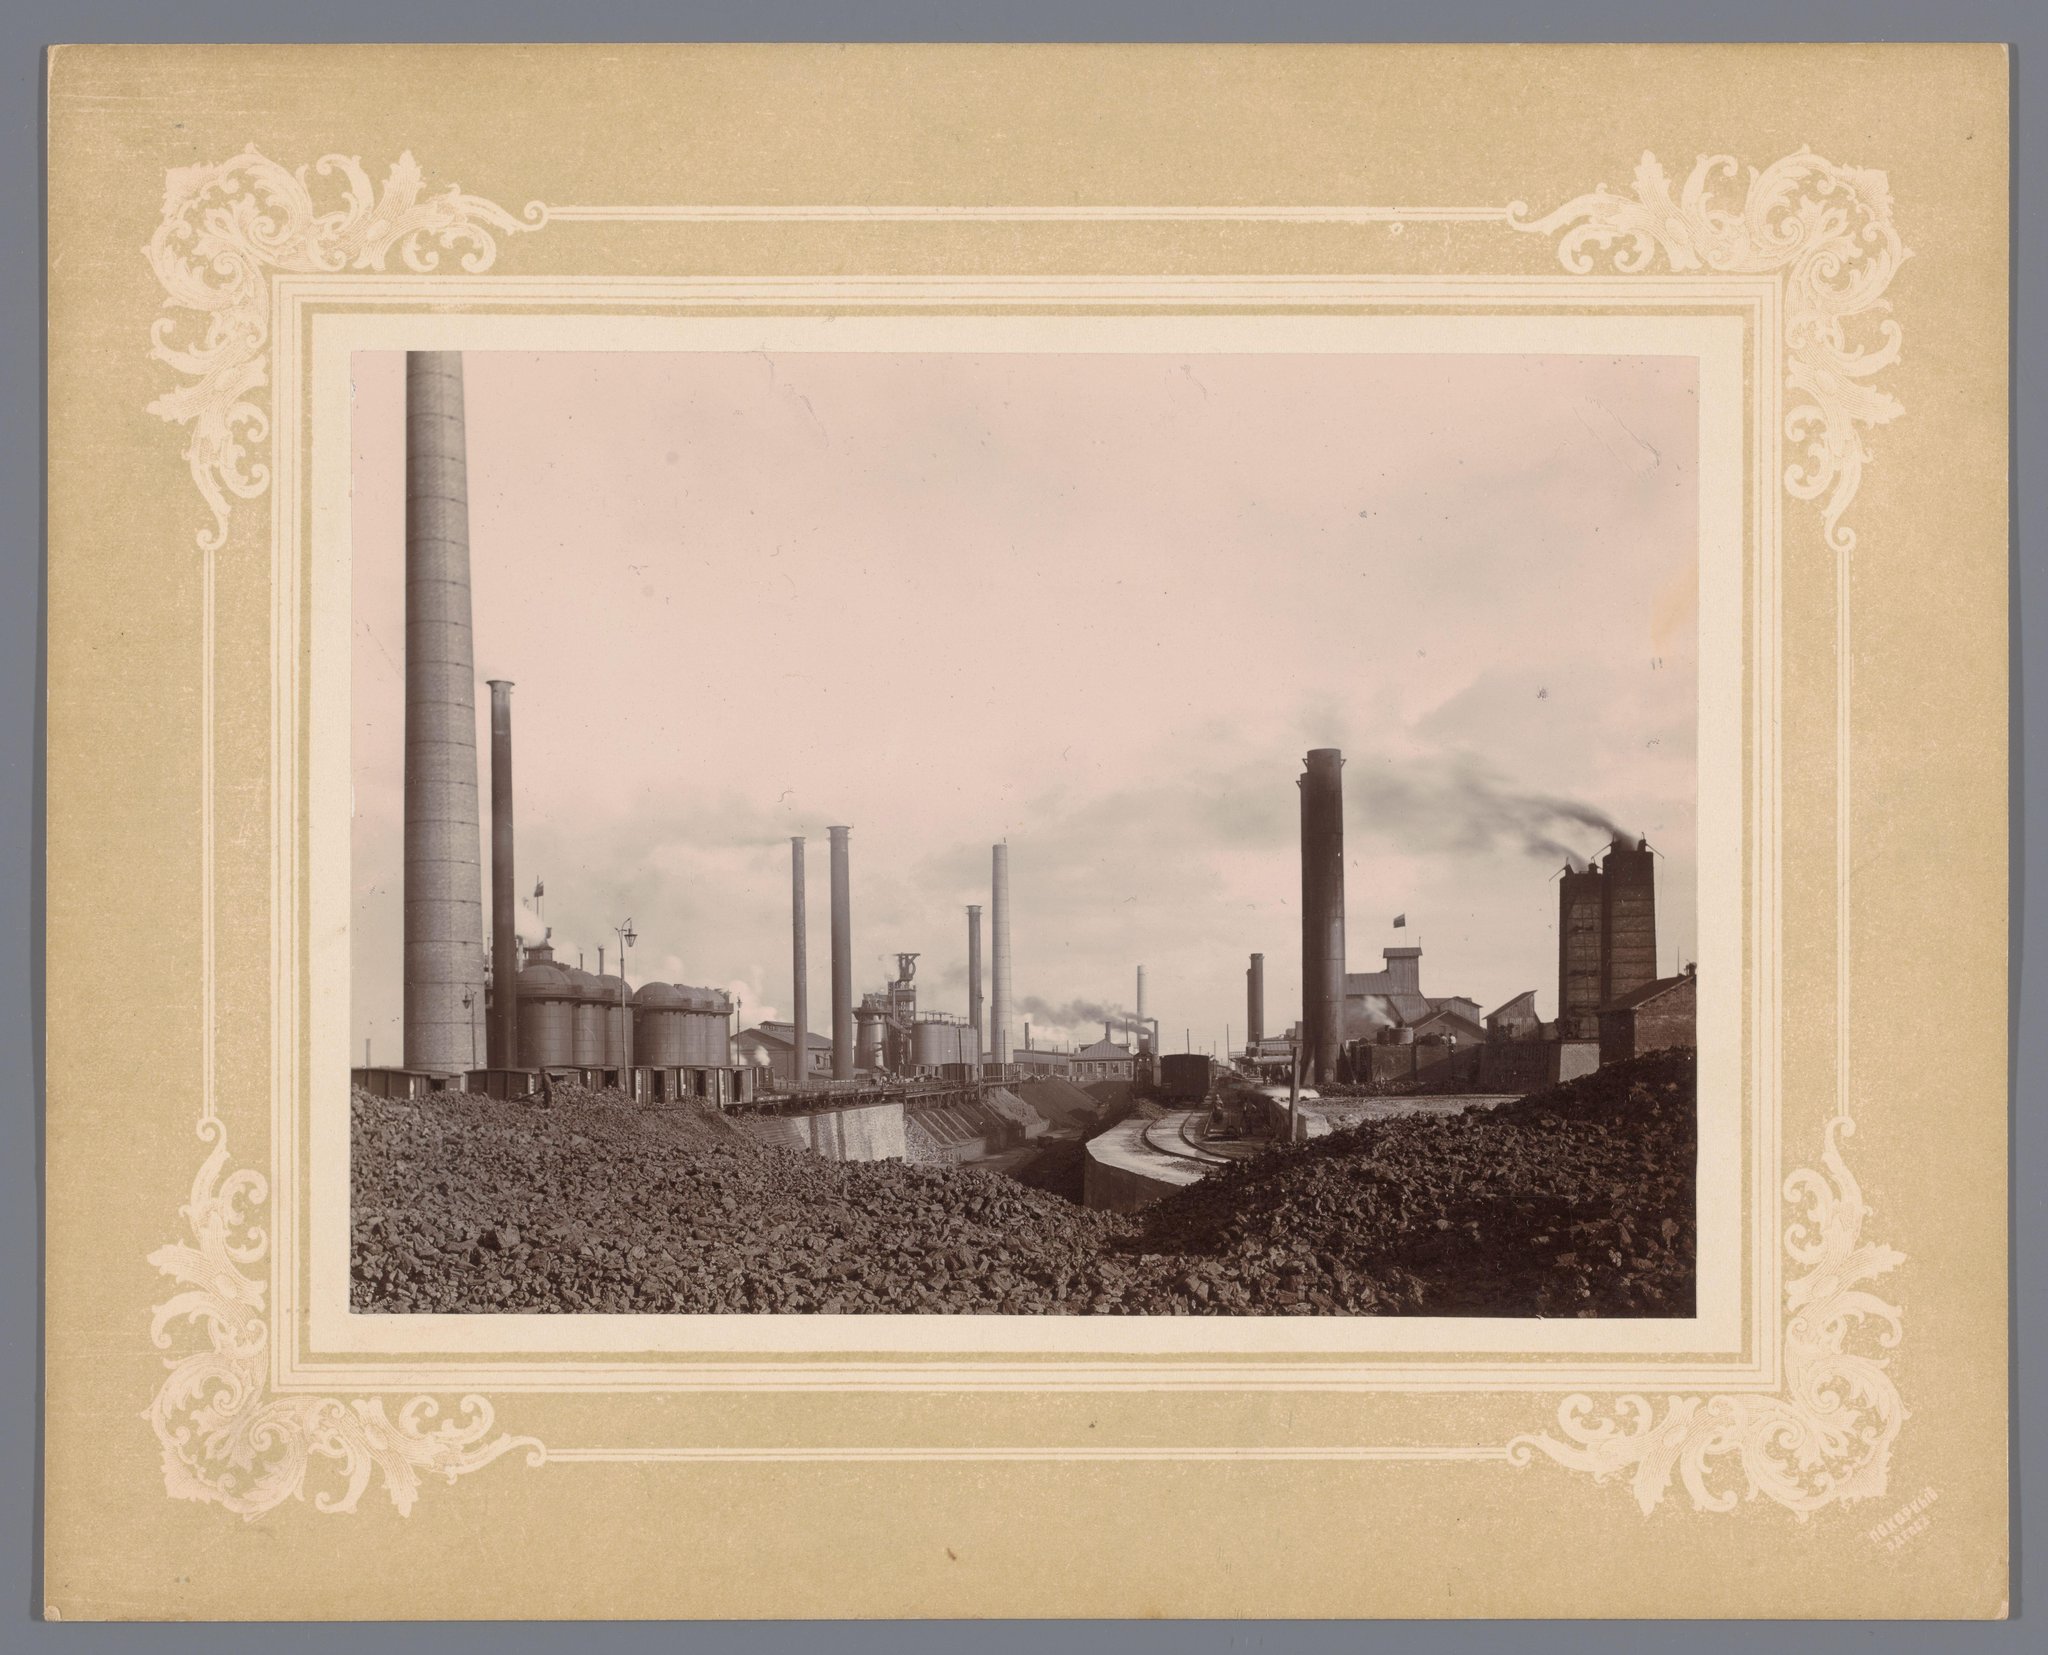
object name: photograph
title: Gezicht op fabrieken in Dnipro, Oekraïne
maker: pokorni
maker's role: fotograaf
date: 1900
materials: cardboard, photographic support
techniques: gelatin silver print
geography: dnipro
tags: factory in landscape